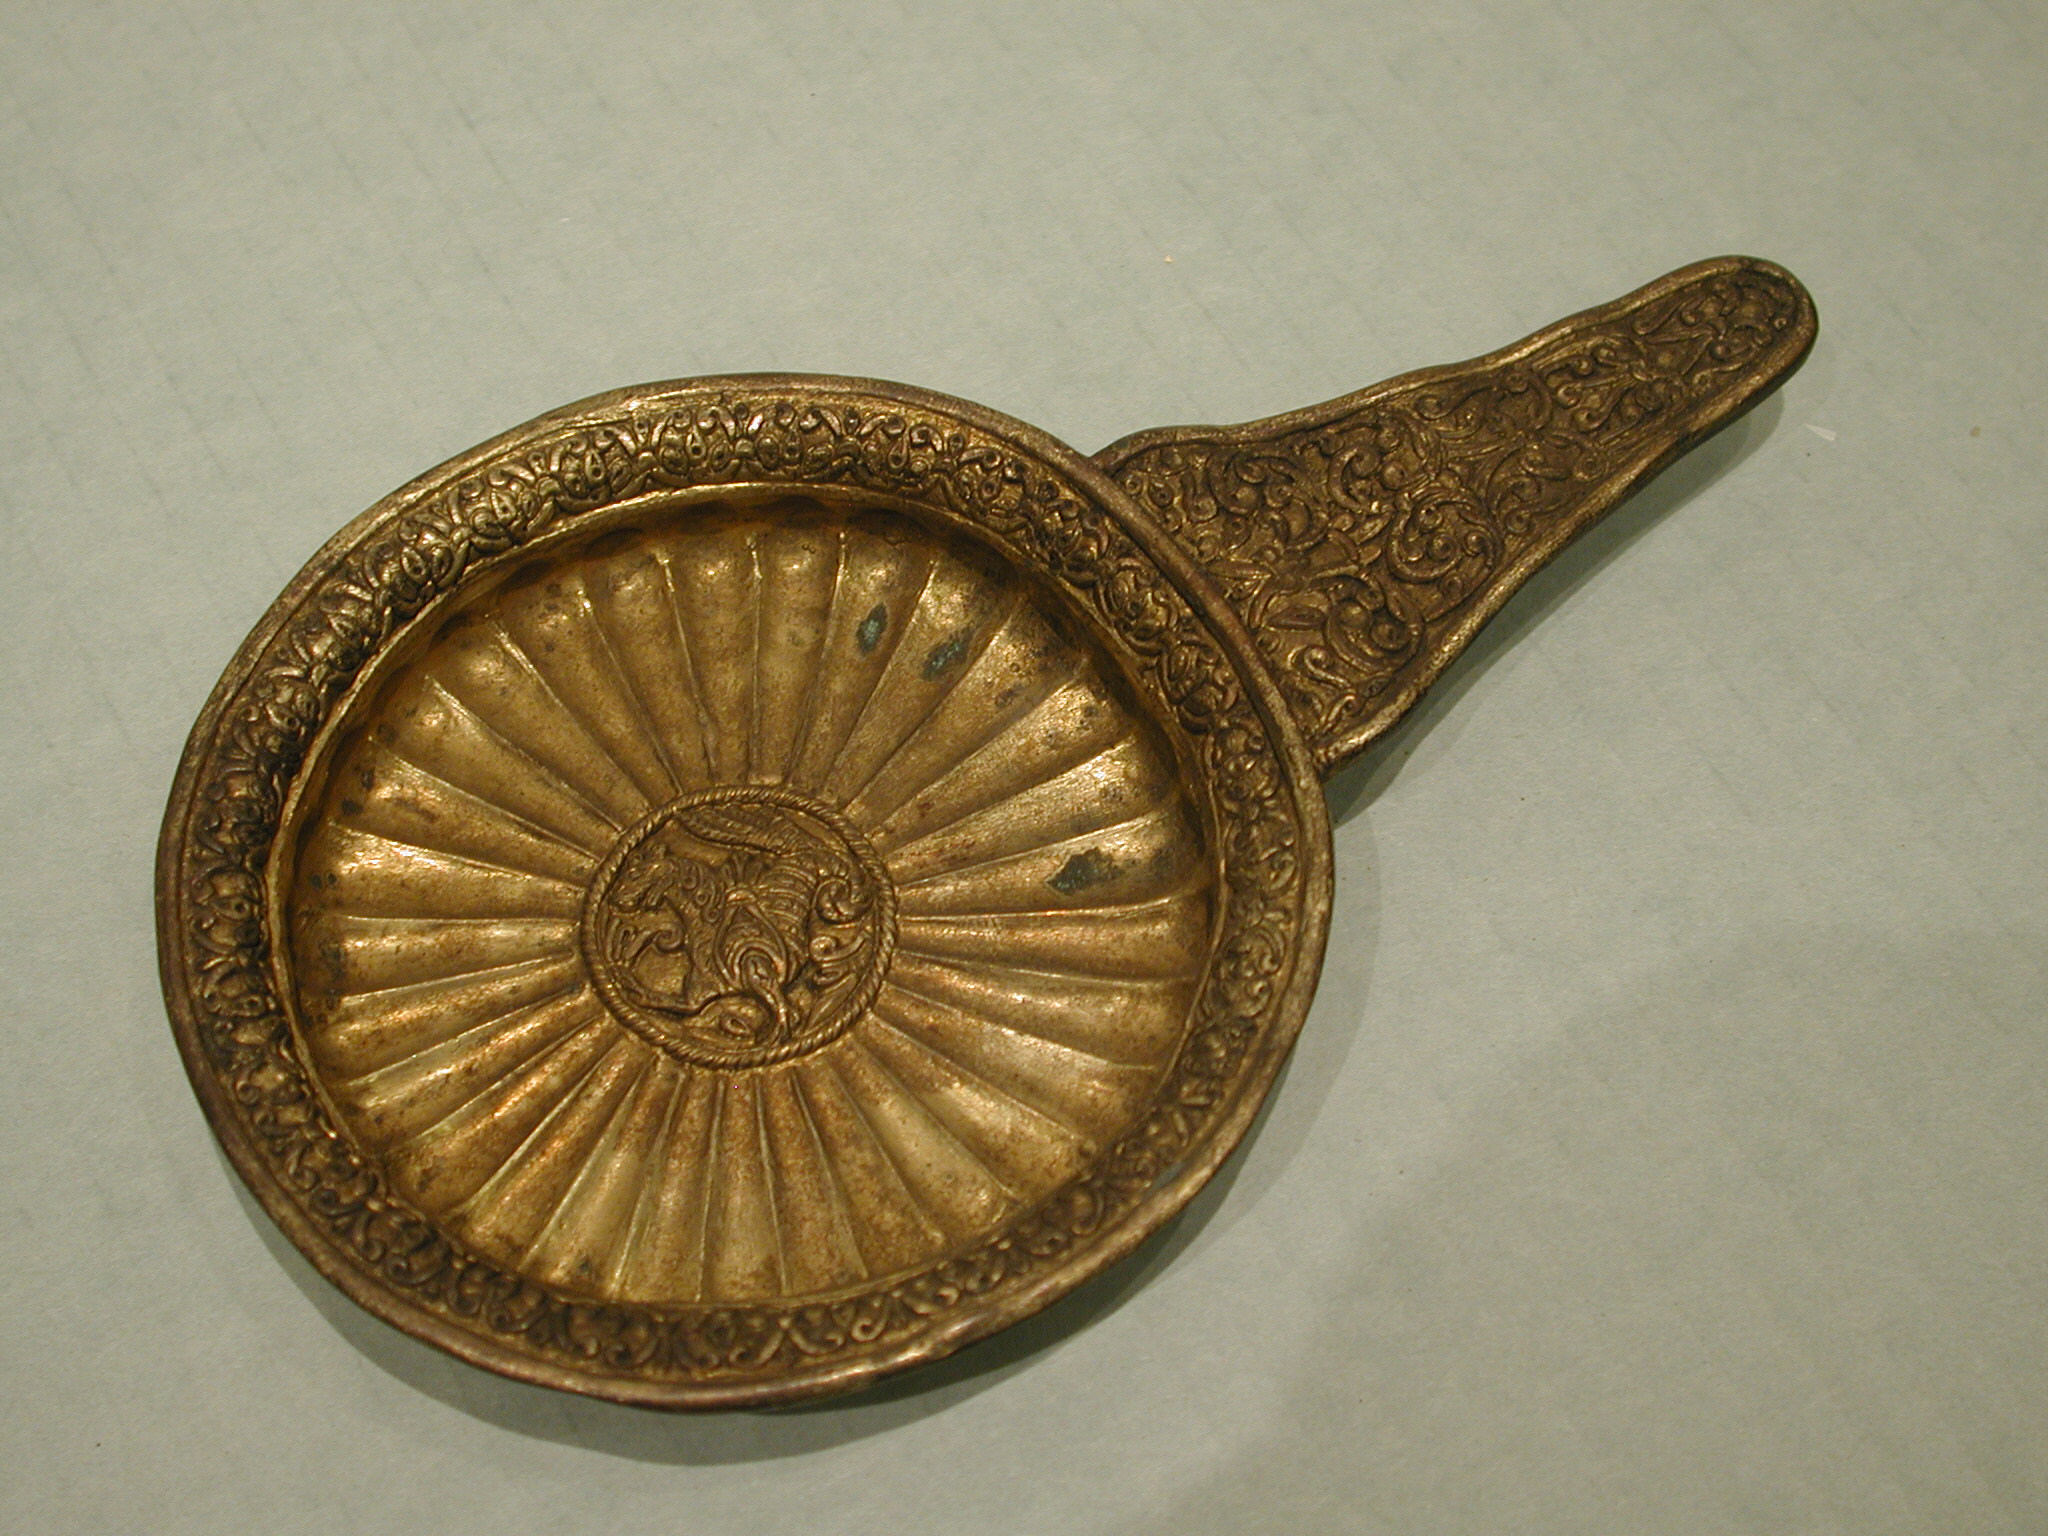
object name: bowl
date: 1801-1900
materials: metal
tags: mythical creatures